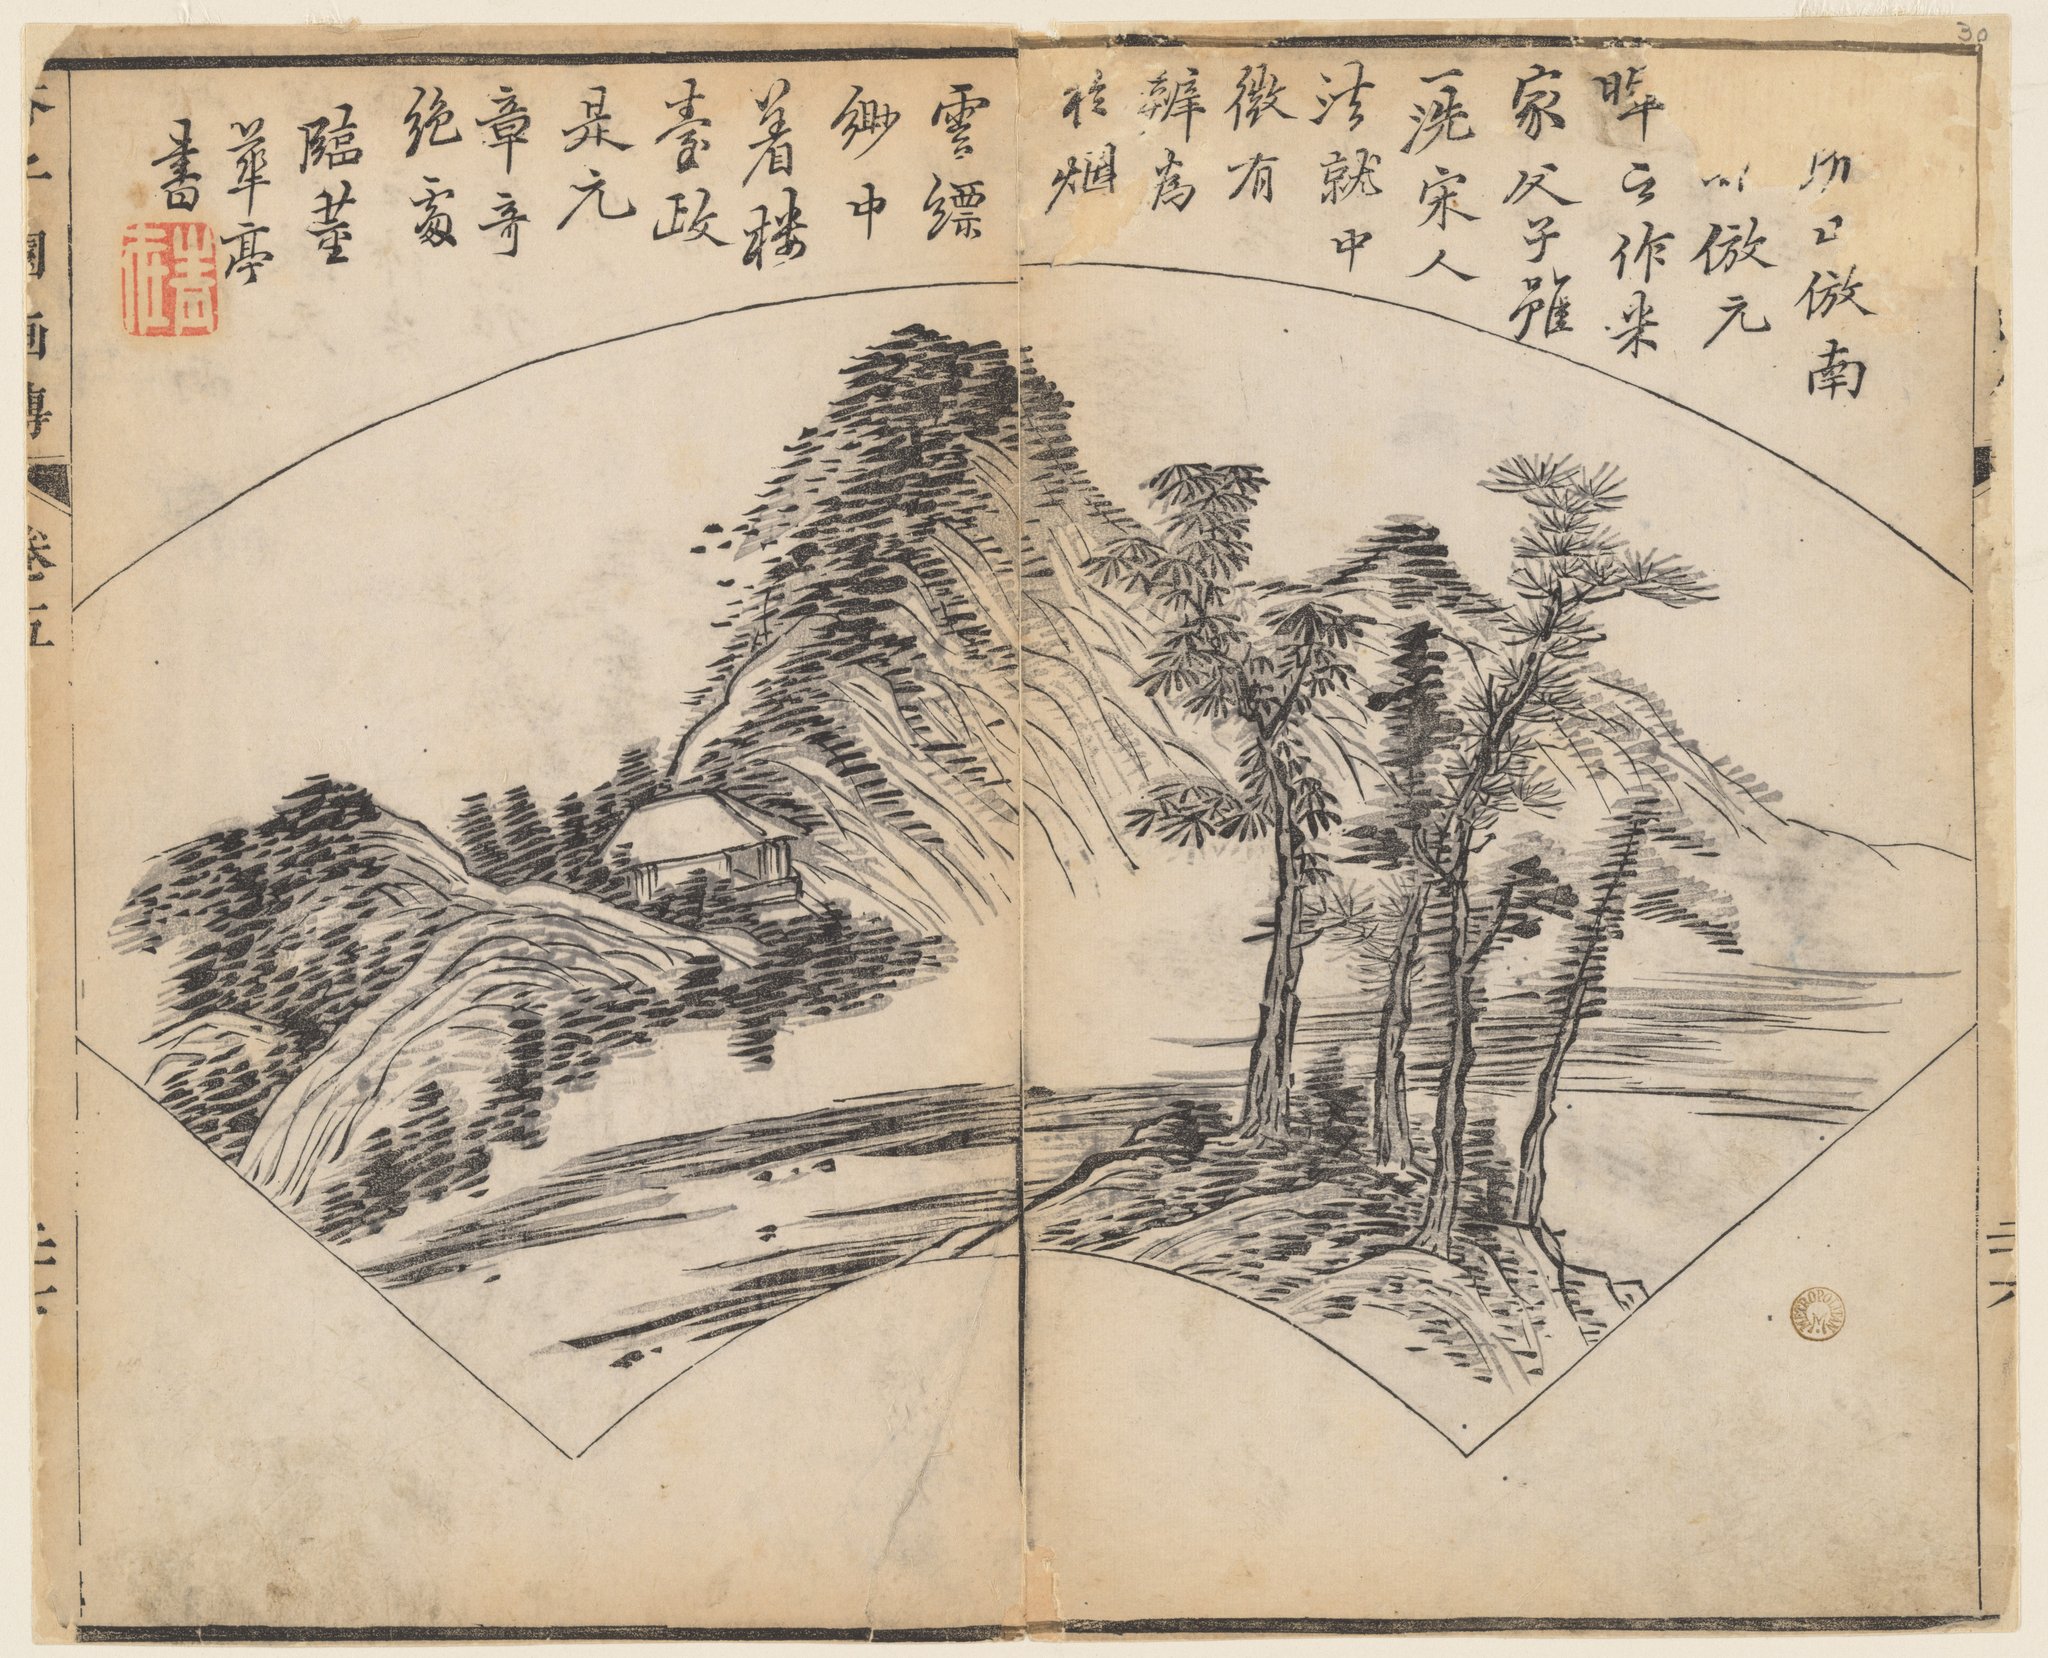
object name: print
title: Page from the Mustard Seed Garden Manual of Painting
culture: chinese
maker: wang gai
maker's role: artist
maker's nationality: chinese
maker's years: 1645-1710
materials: ink, paper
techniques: woodblock print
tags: mountains,landscapes